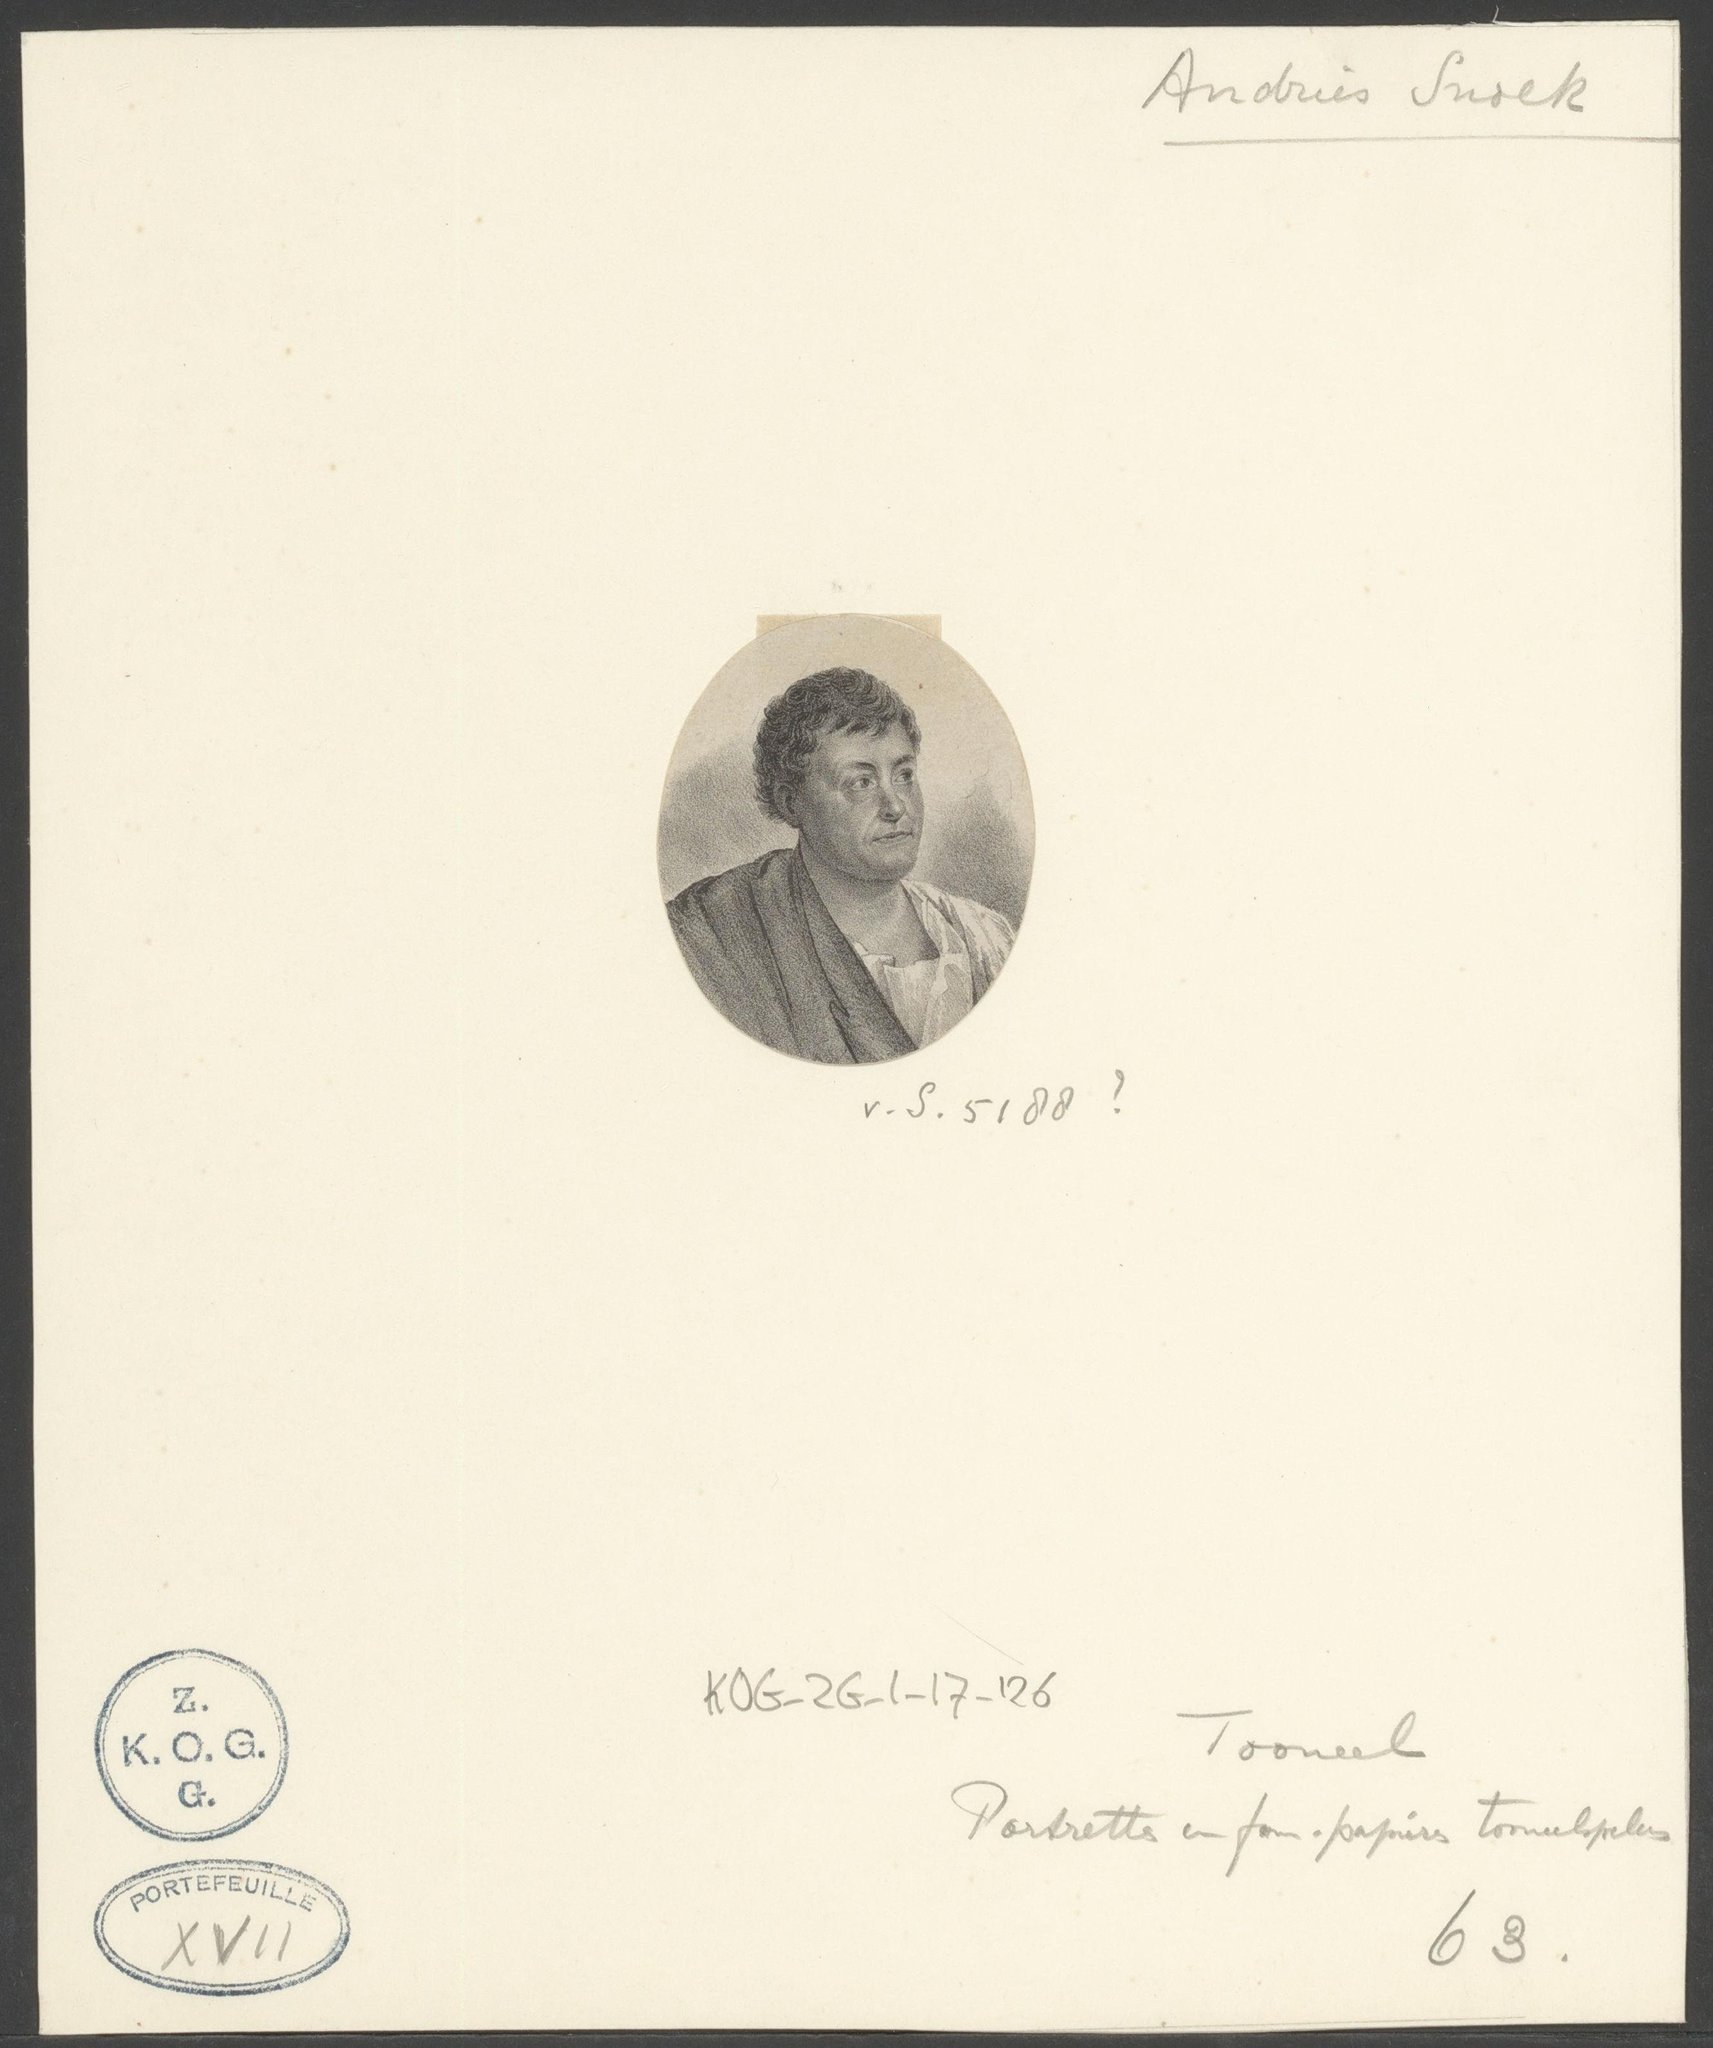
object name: print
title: Portret van Andreas Snoek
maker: Anonymous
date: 1828-1849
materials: paper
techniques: lithograph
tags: rotterdam, historical persons, portrait of actor, actress, actor (on the stage)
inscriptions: stamp, collector's mark: Lugt 1641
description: Onderwerpsrubrieken binnen de Atlas Zeden en Gewoonten: Tooneel, Portretten van toneelspelers.